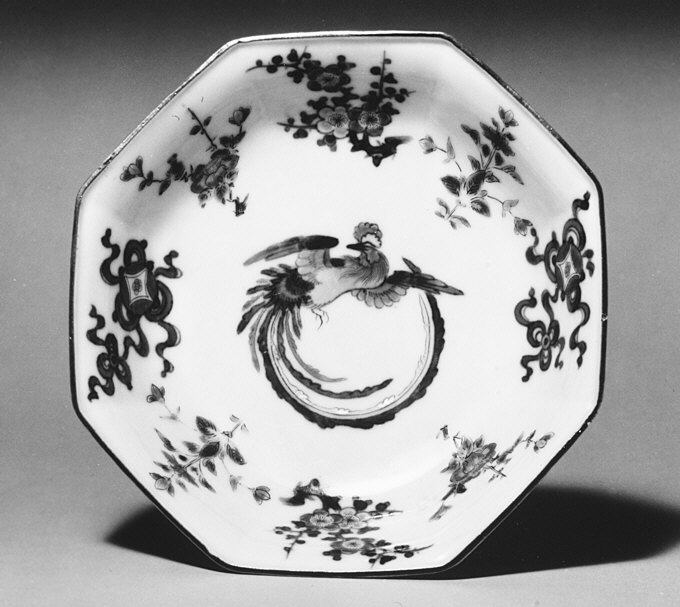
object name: dish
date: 1690-1710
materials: hard paste porcelain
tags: birds,flowers